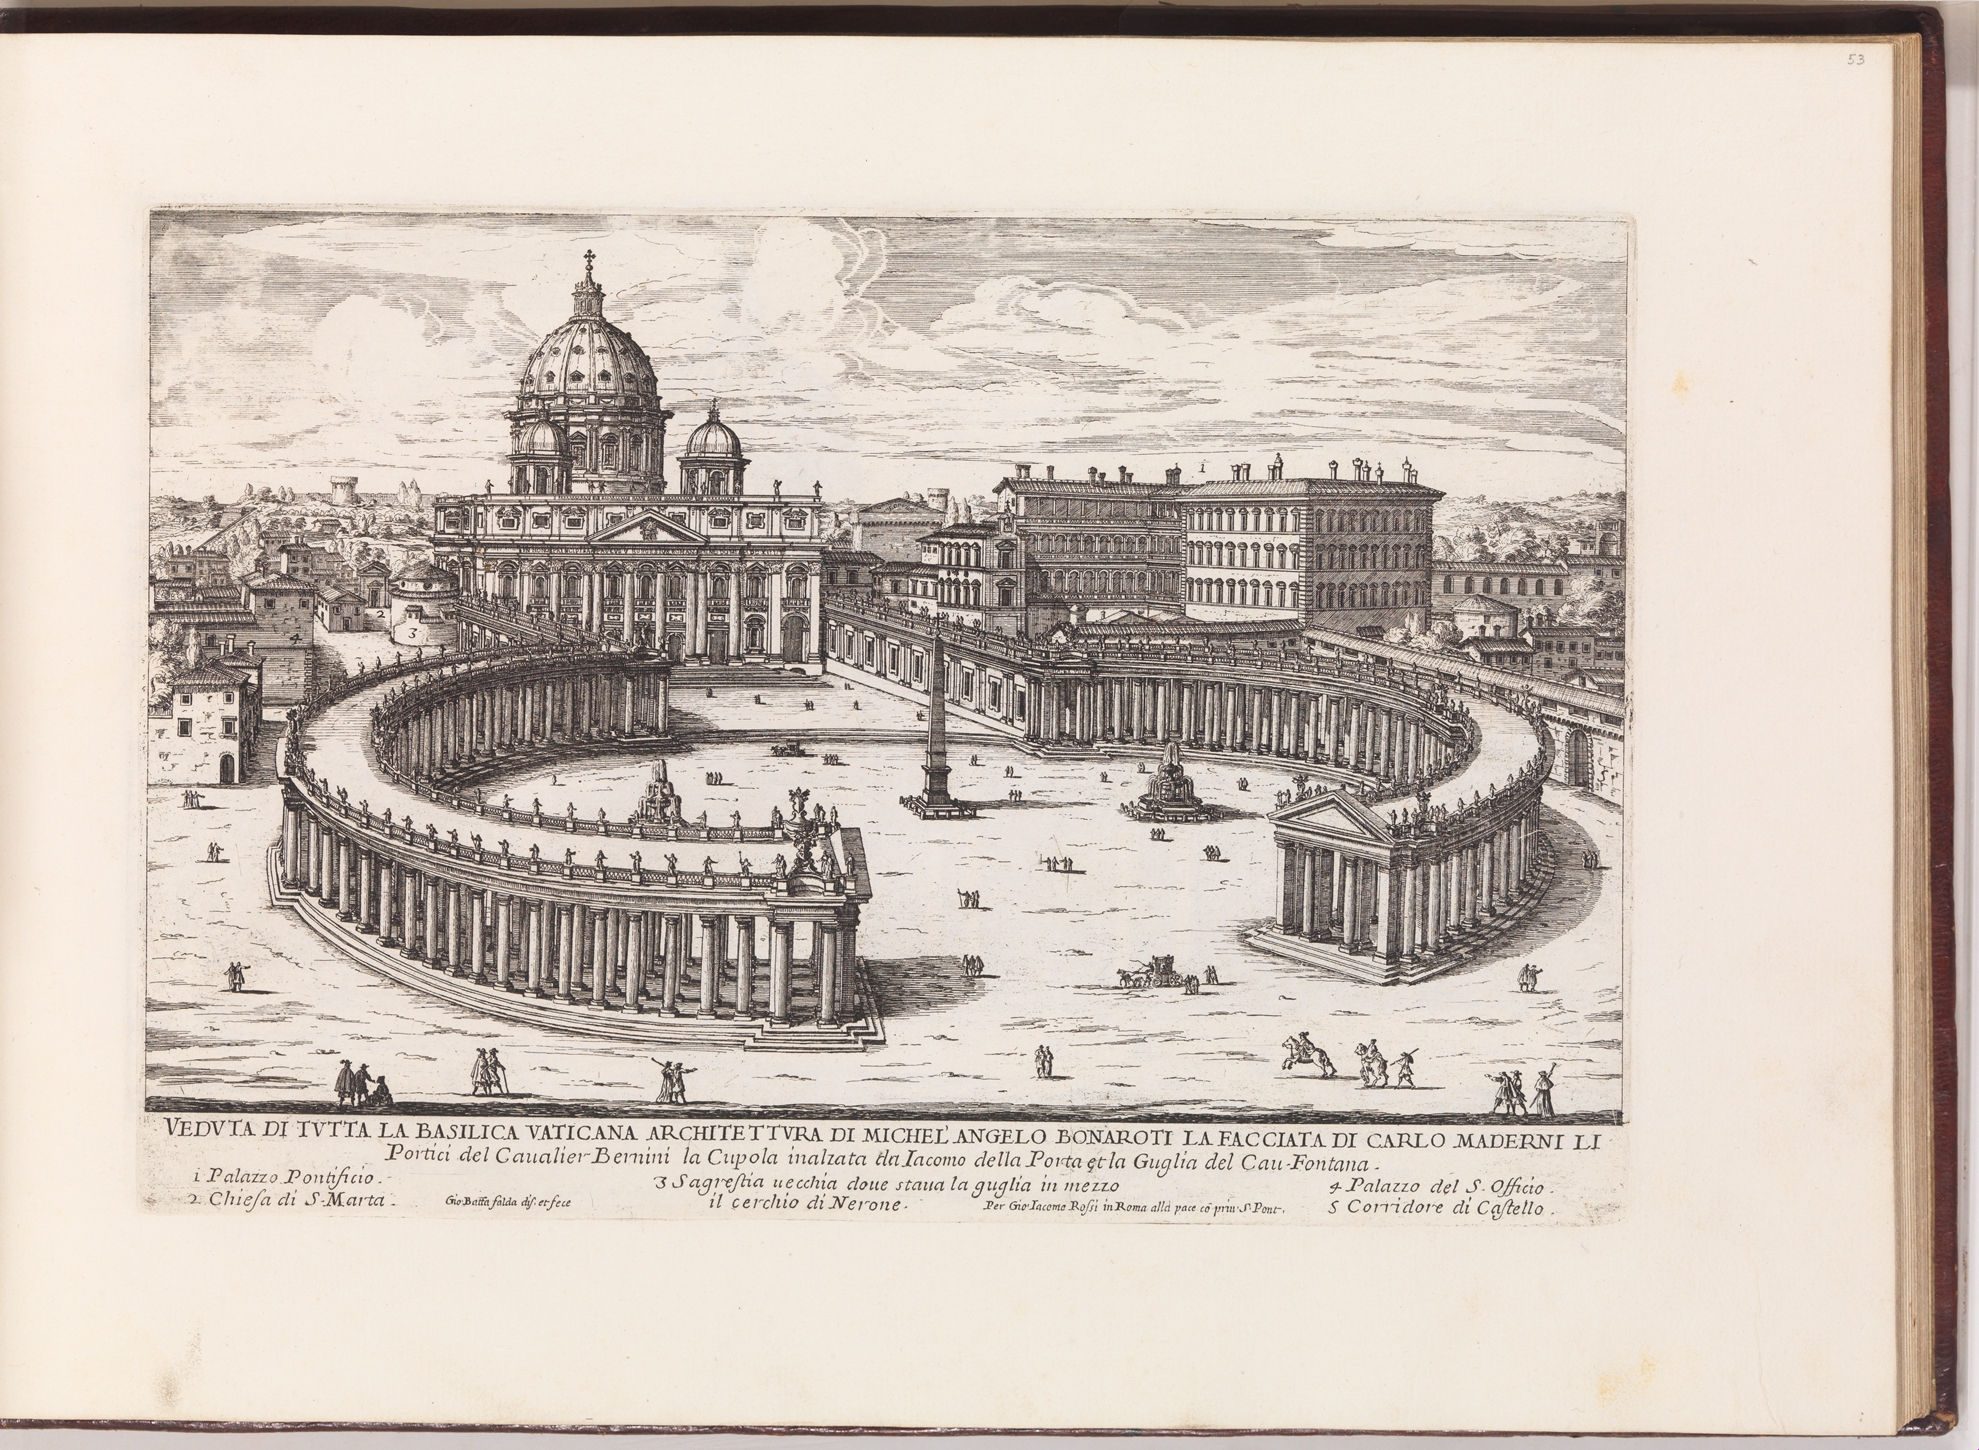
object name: collection ornament architecture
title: Veduta di Tutta la Basilica Vaticana (...) from: Il Nuovo Teatro delle Fabbriche, et Edificii, in Prospettiva di Rome Moderna (...)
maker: giovanni battista falda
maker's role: artist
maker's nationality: italian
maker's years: 1643-1678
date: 1665-1669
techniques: etching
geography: italy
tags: architecture,churches,rome